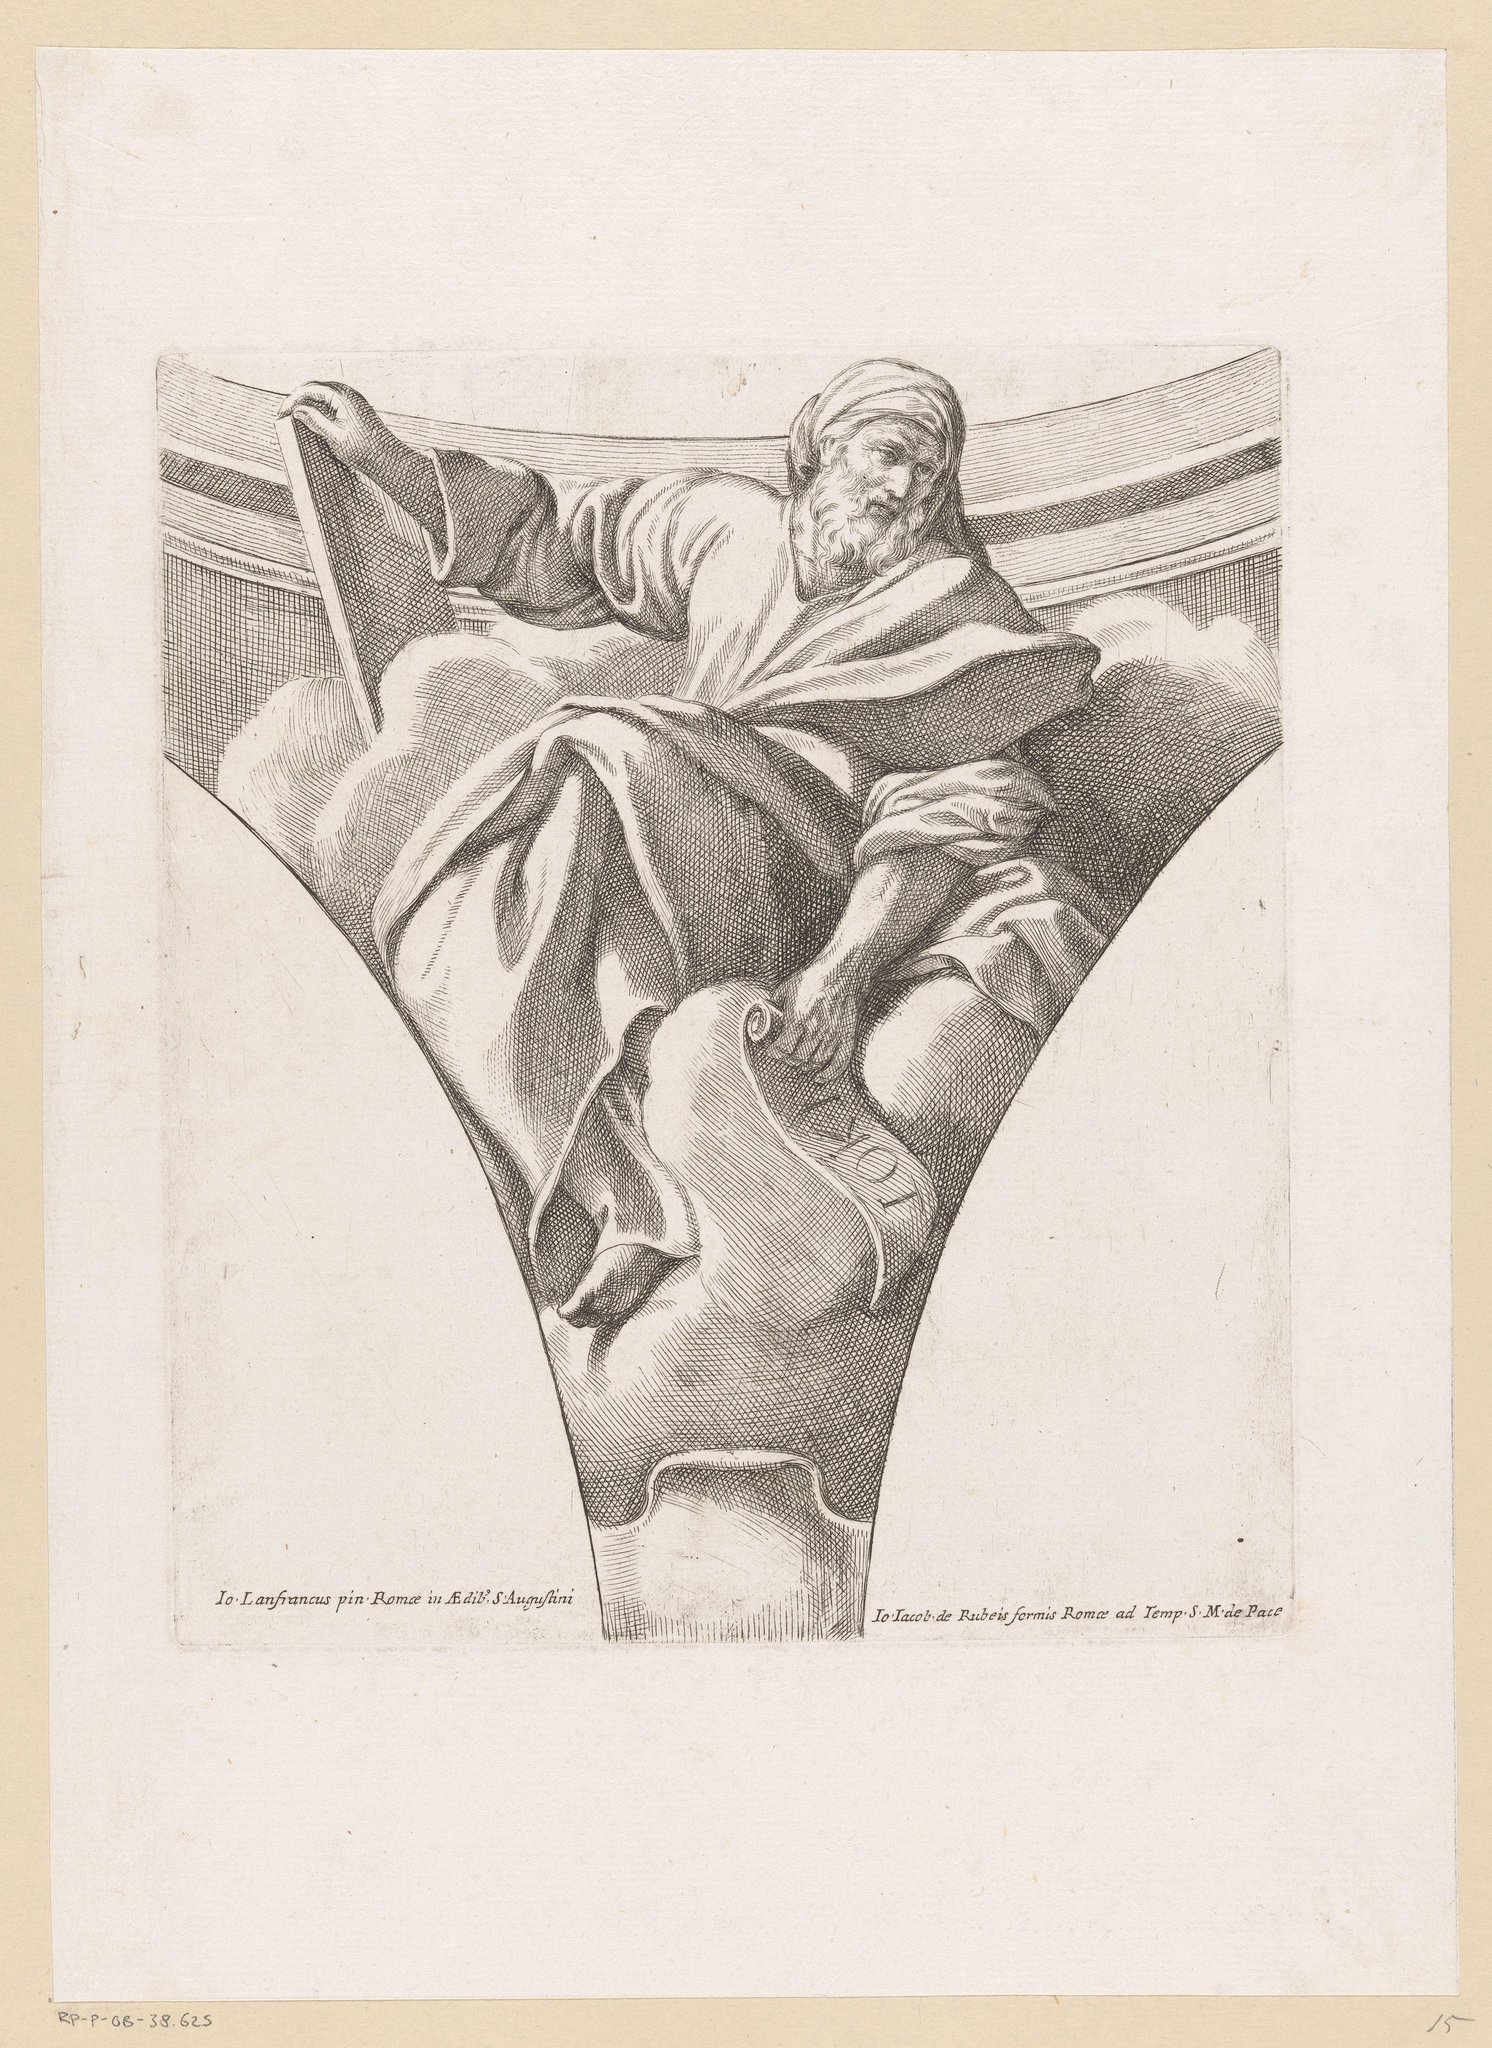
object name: print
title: Schilderingen in de Cappella Buongiovanni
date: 1632-1682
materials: paper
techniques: etching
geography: italy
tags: evangelists, usually with books or scrolls (not in biblical context)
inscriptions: collector's mark: Lugt 240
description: Deze prent maakt deel uit van een serie van negen prenten naar schilderingen door Giovanni Lanfranco in de Cappella Buongiovanni in de Sant'Agostino te Rome.